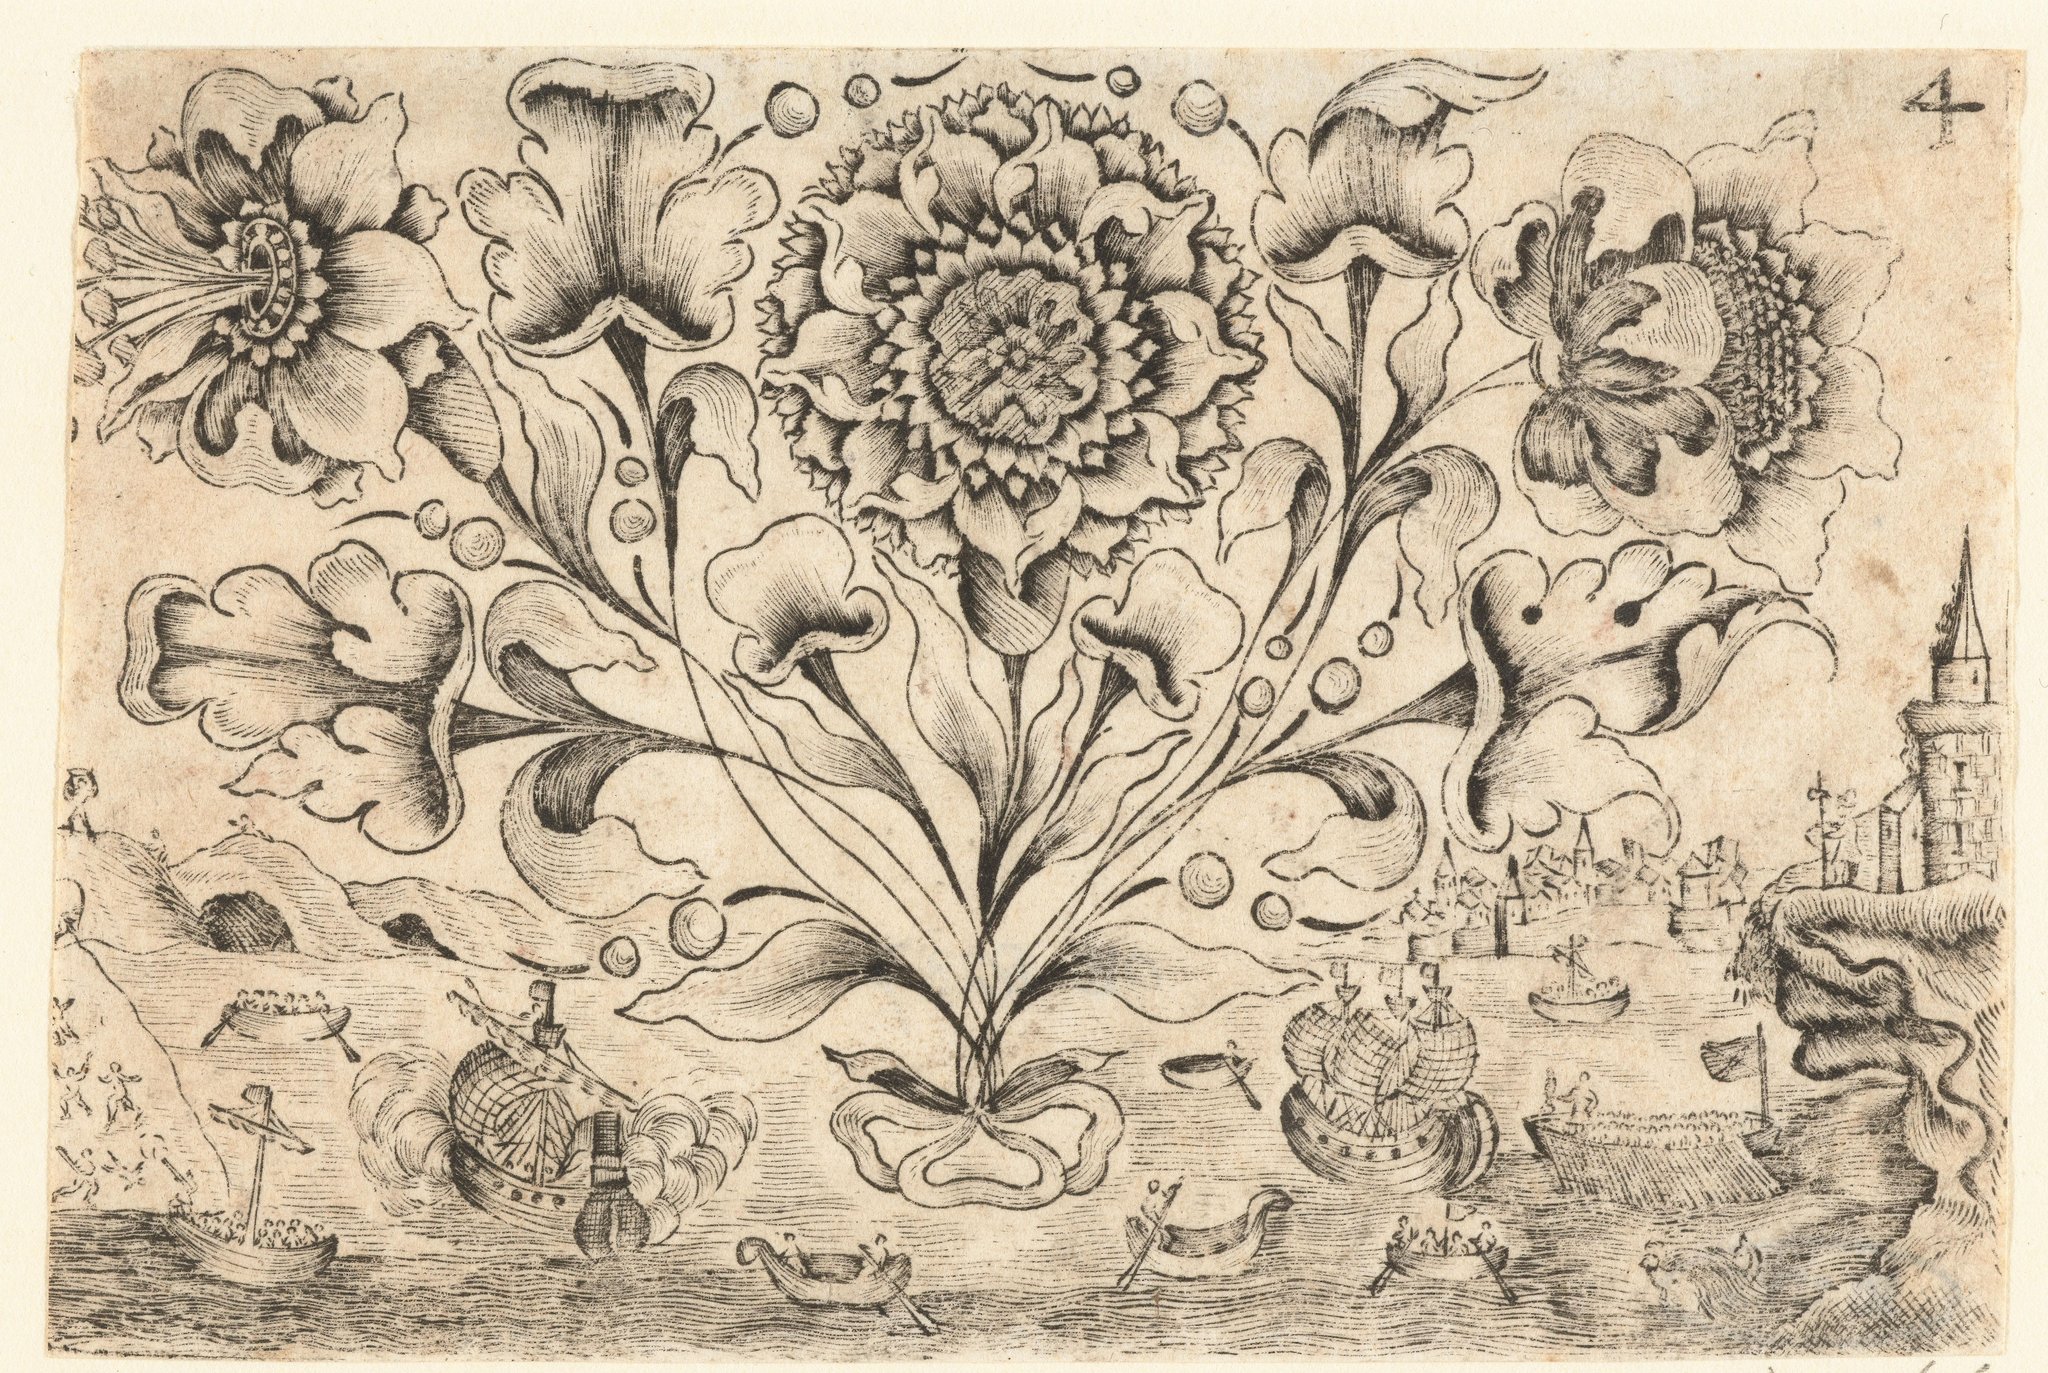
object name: print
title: Neues Blumen und Lauberbüchlein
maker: Anonymous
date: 1600-1699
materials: paper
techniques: etching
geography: germany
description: De achtergrond bestaat uit een rivier waar een zeeslag plaatsvindt. Blad 4 uit serie boeketten in Franse peulvruchtenstijl.